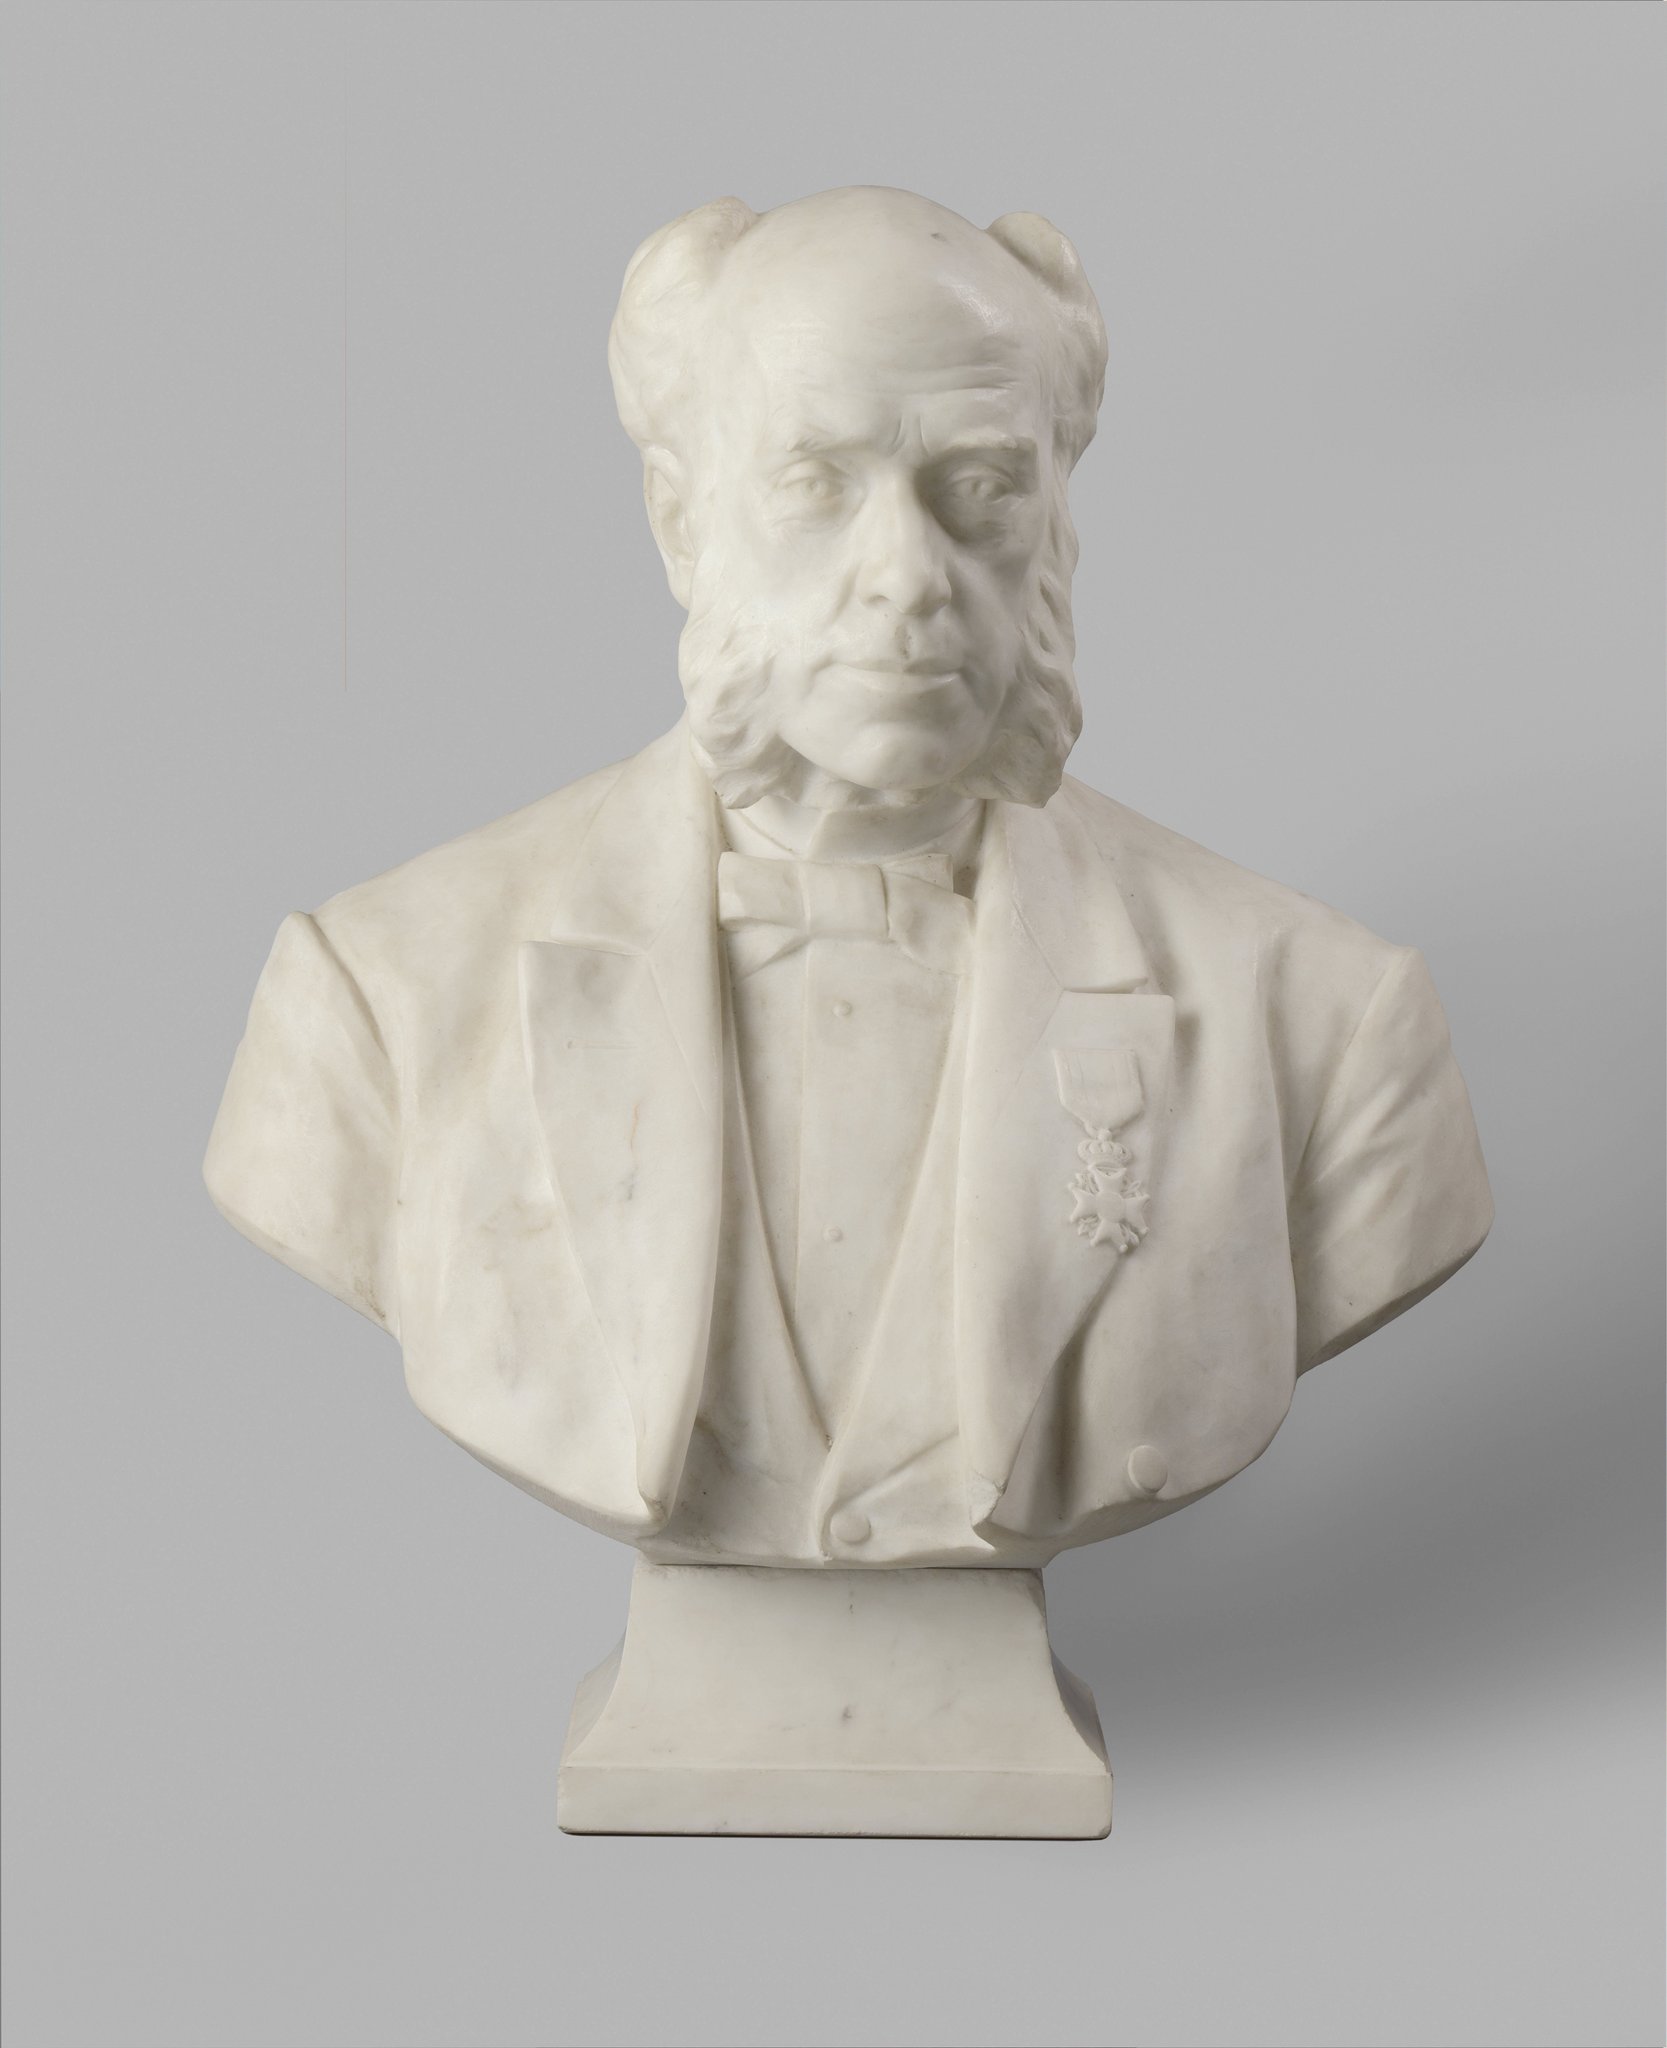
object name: pedestal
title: Buste van dr. Eliza Laurillard (1830-1908), dominee en schrijver en twee sokkels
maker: arend willem maurits odé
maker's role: sculptor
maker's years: 1865-1955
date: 1894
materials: marble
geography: netherlands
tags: eliza laurillard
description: De buste heeft een voetstuk van wit marmer en een rood, zwart en grijs gevlekte sokkel van graniet.